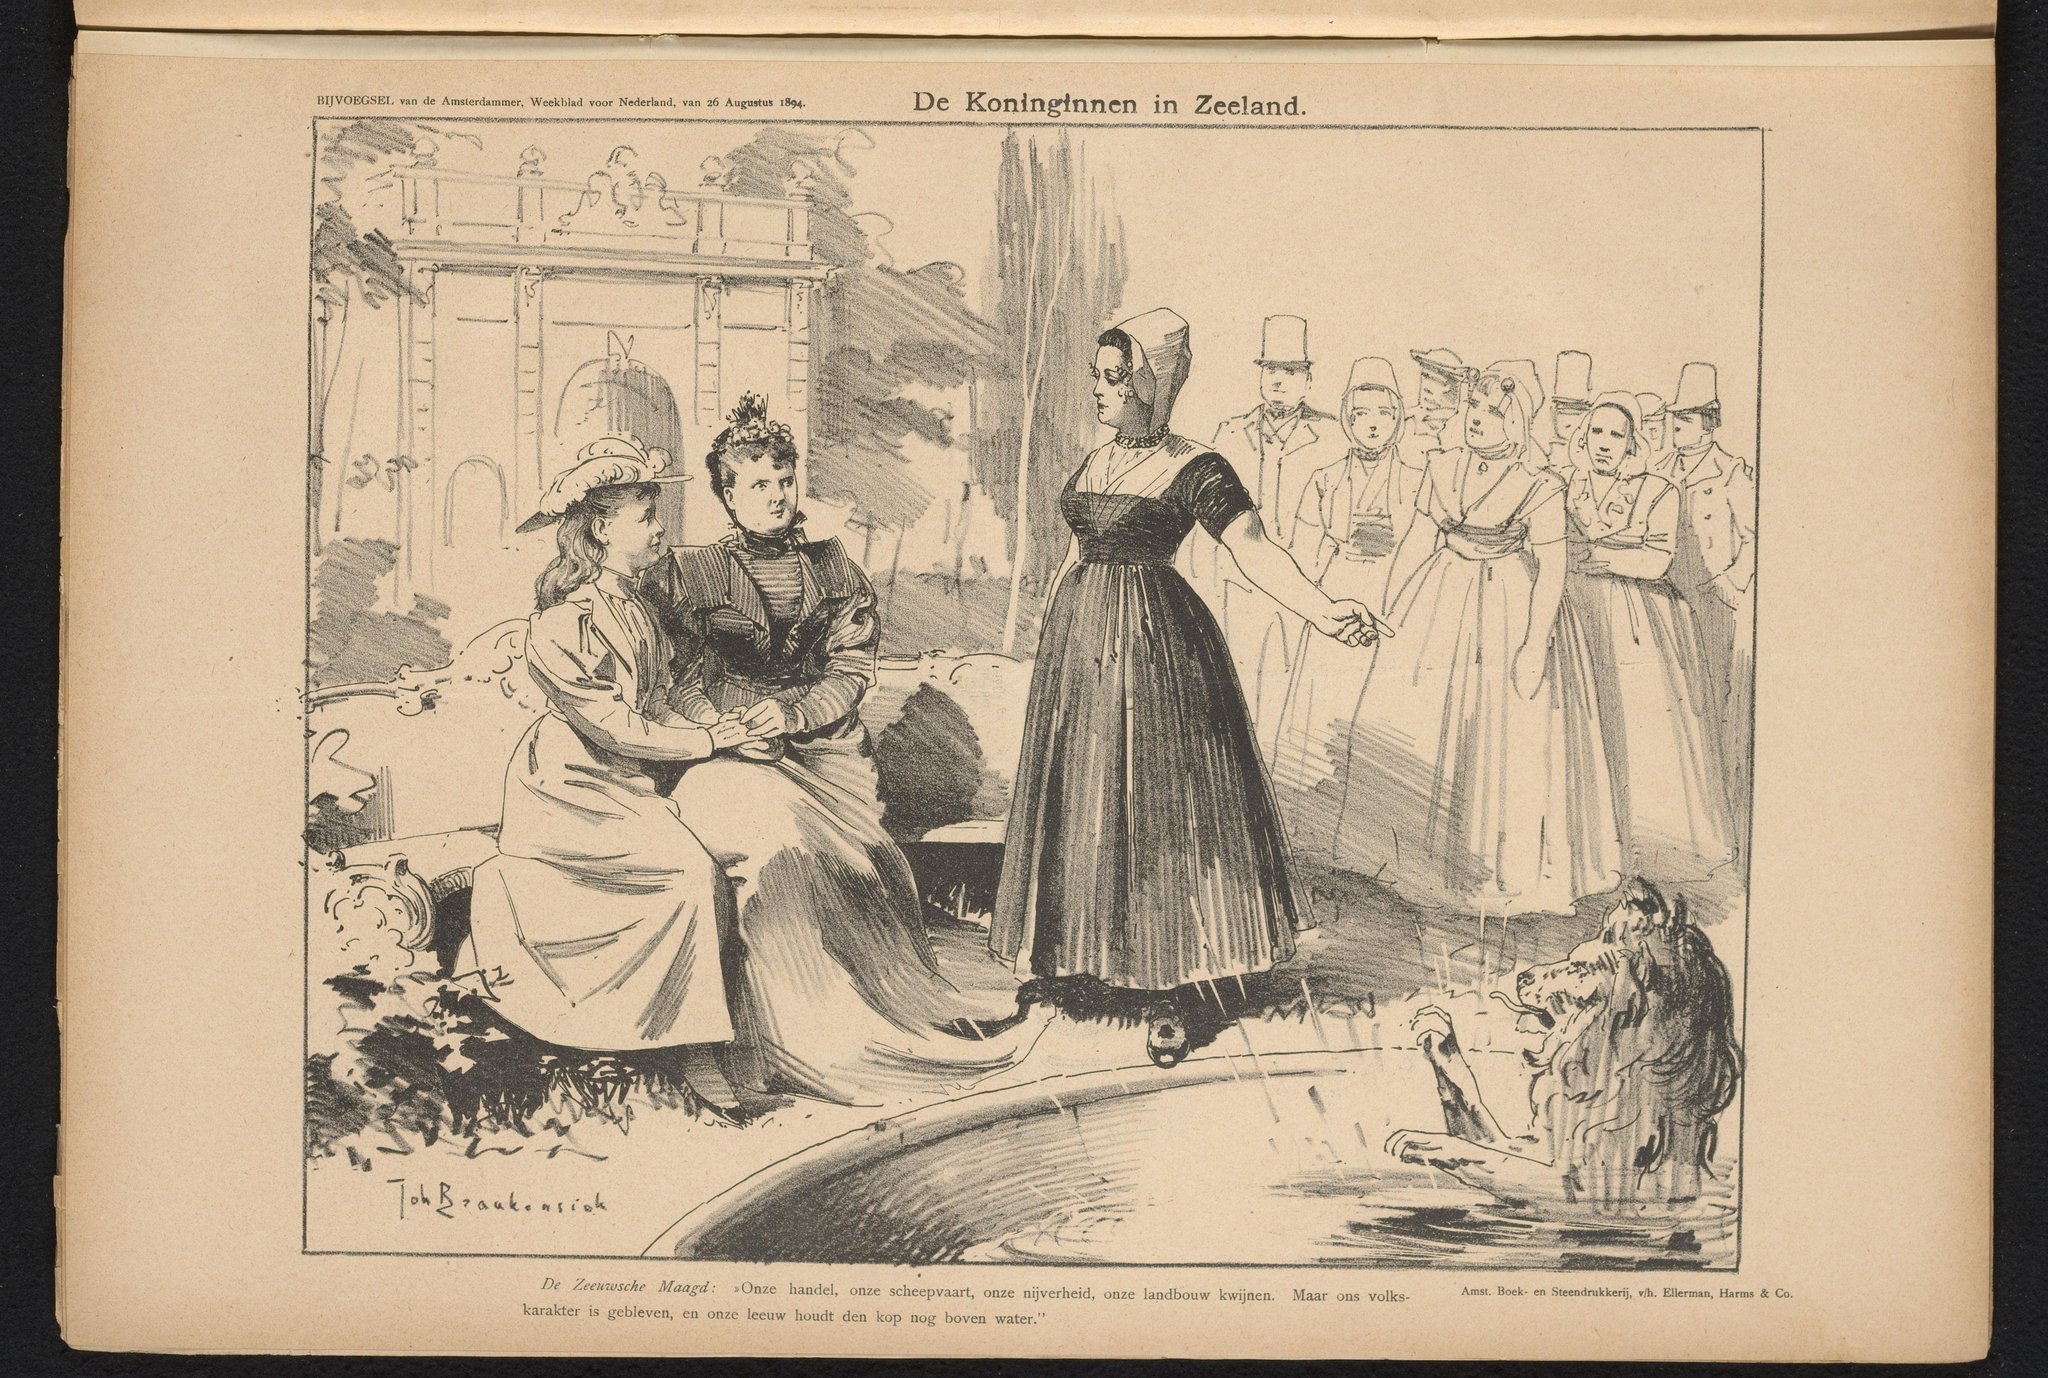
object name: cartoon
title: De Koninginnen in Zeeland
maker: johan braakensiek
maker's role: draughtsman, print maker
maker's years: 1858-1940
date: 1894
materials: paper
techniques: lithograph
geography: netherlands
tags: the hague, print maker, wilhelmina of the netherlands, juliana of the netherlands, personifications of countries, nations, states, districts, etc., folk costume, regional costume, political caricatures and satires, zeeland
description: Koningin Wilhelmina en prinses Juliana op bezoek in Zeeland worden namens alle Zeeuwen toegesproken door de Zeeuwse Maagd over de zorgwekkende economische toestand van de provincie. Rechts de Zeeuwse leeuw die worstelend de kop nog boven water houdt.